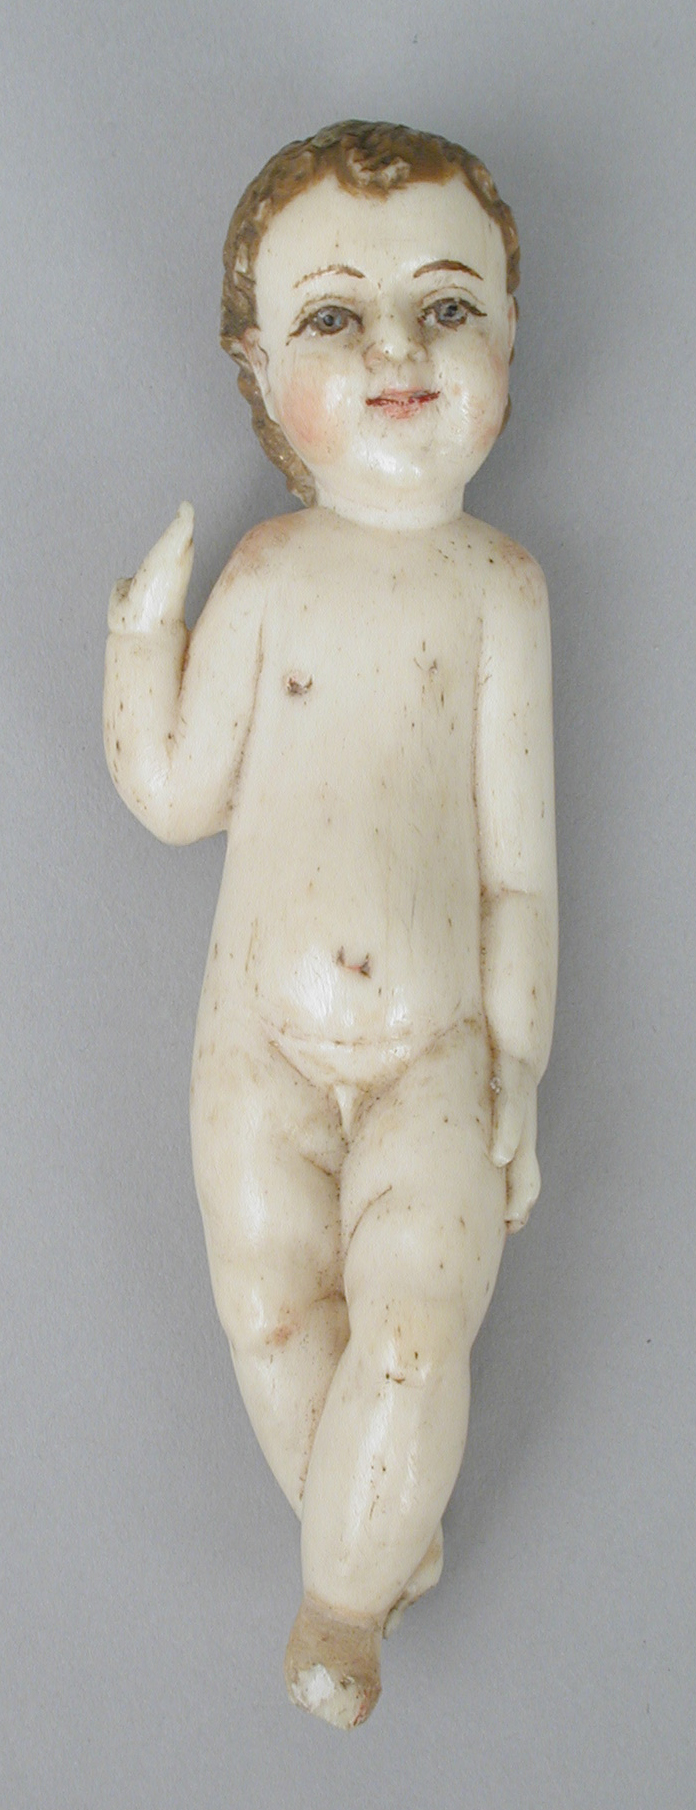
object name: statuette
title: Child Jesus (from a nativity)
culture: ecuadorian or philippine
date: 1701-1800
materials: ivory, wood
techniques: gilding, polychrome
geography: philippines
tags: infants,jesus